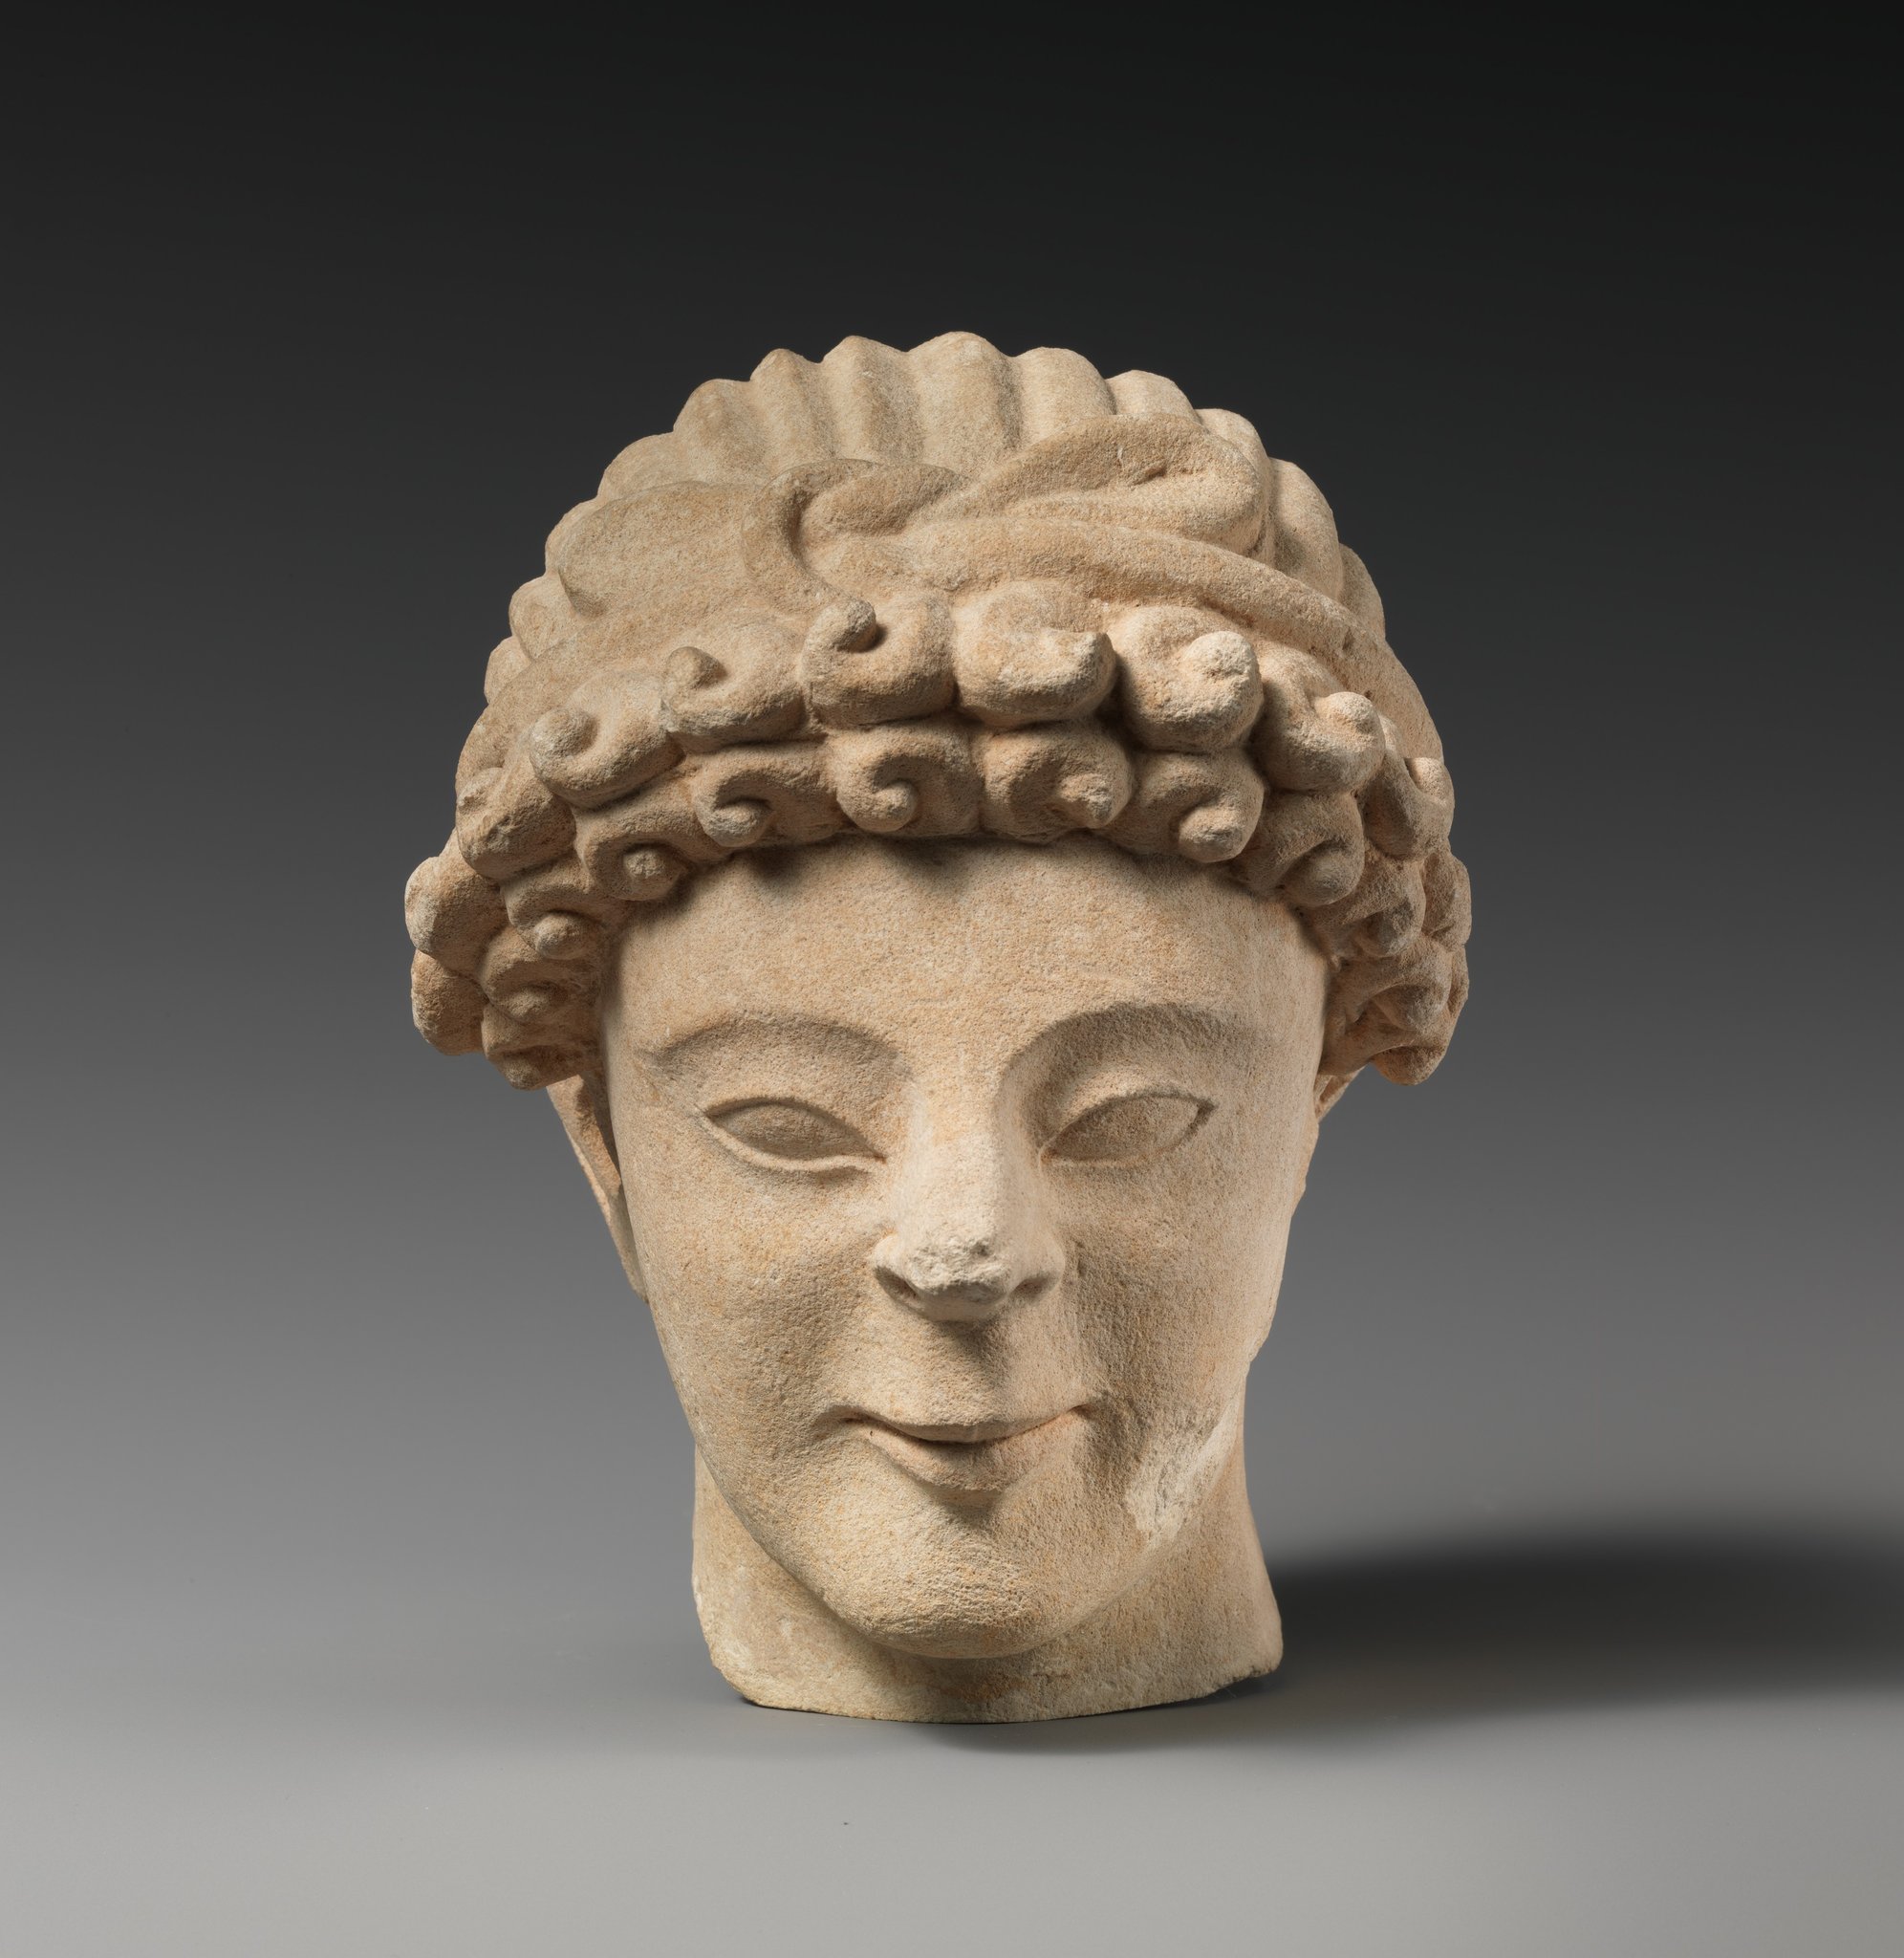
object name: male head, beardless, wearing a wreath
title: Limestone head of male votary with fillet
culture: cypriot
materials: limestone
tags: heads,men